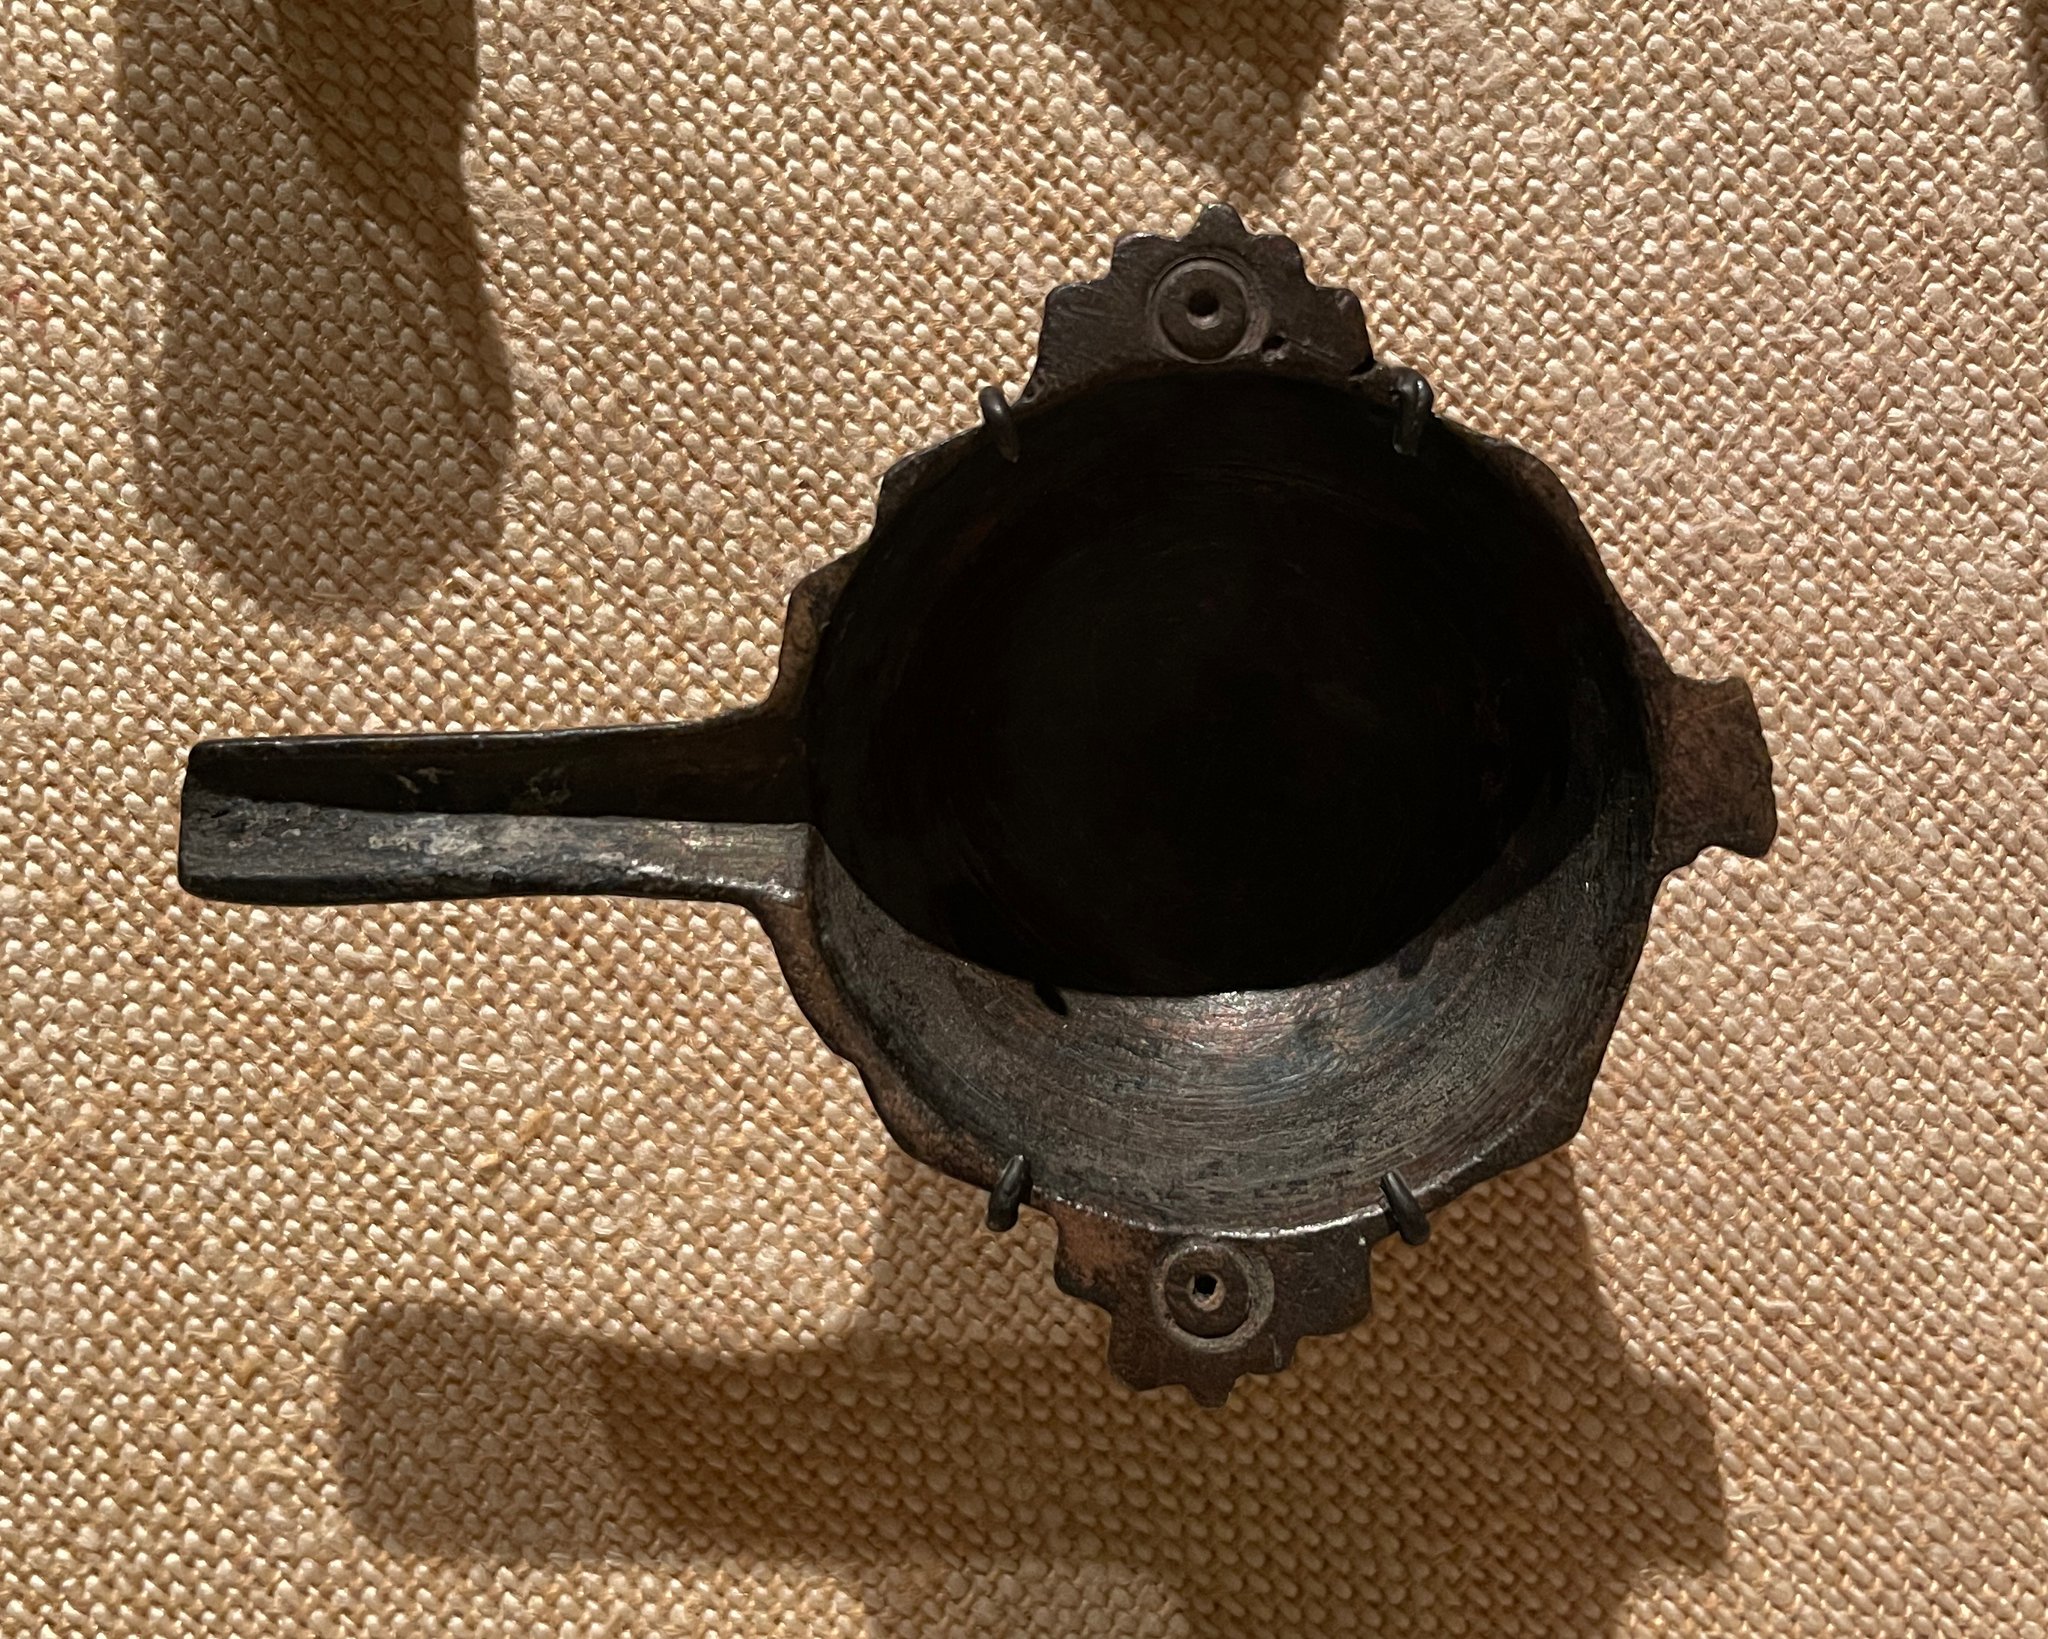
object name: mortar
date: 801-1000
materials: bronze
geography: iran